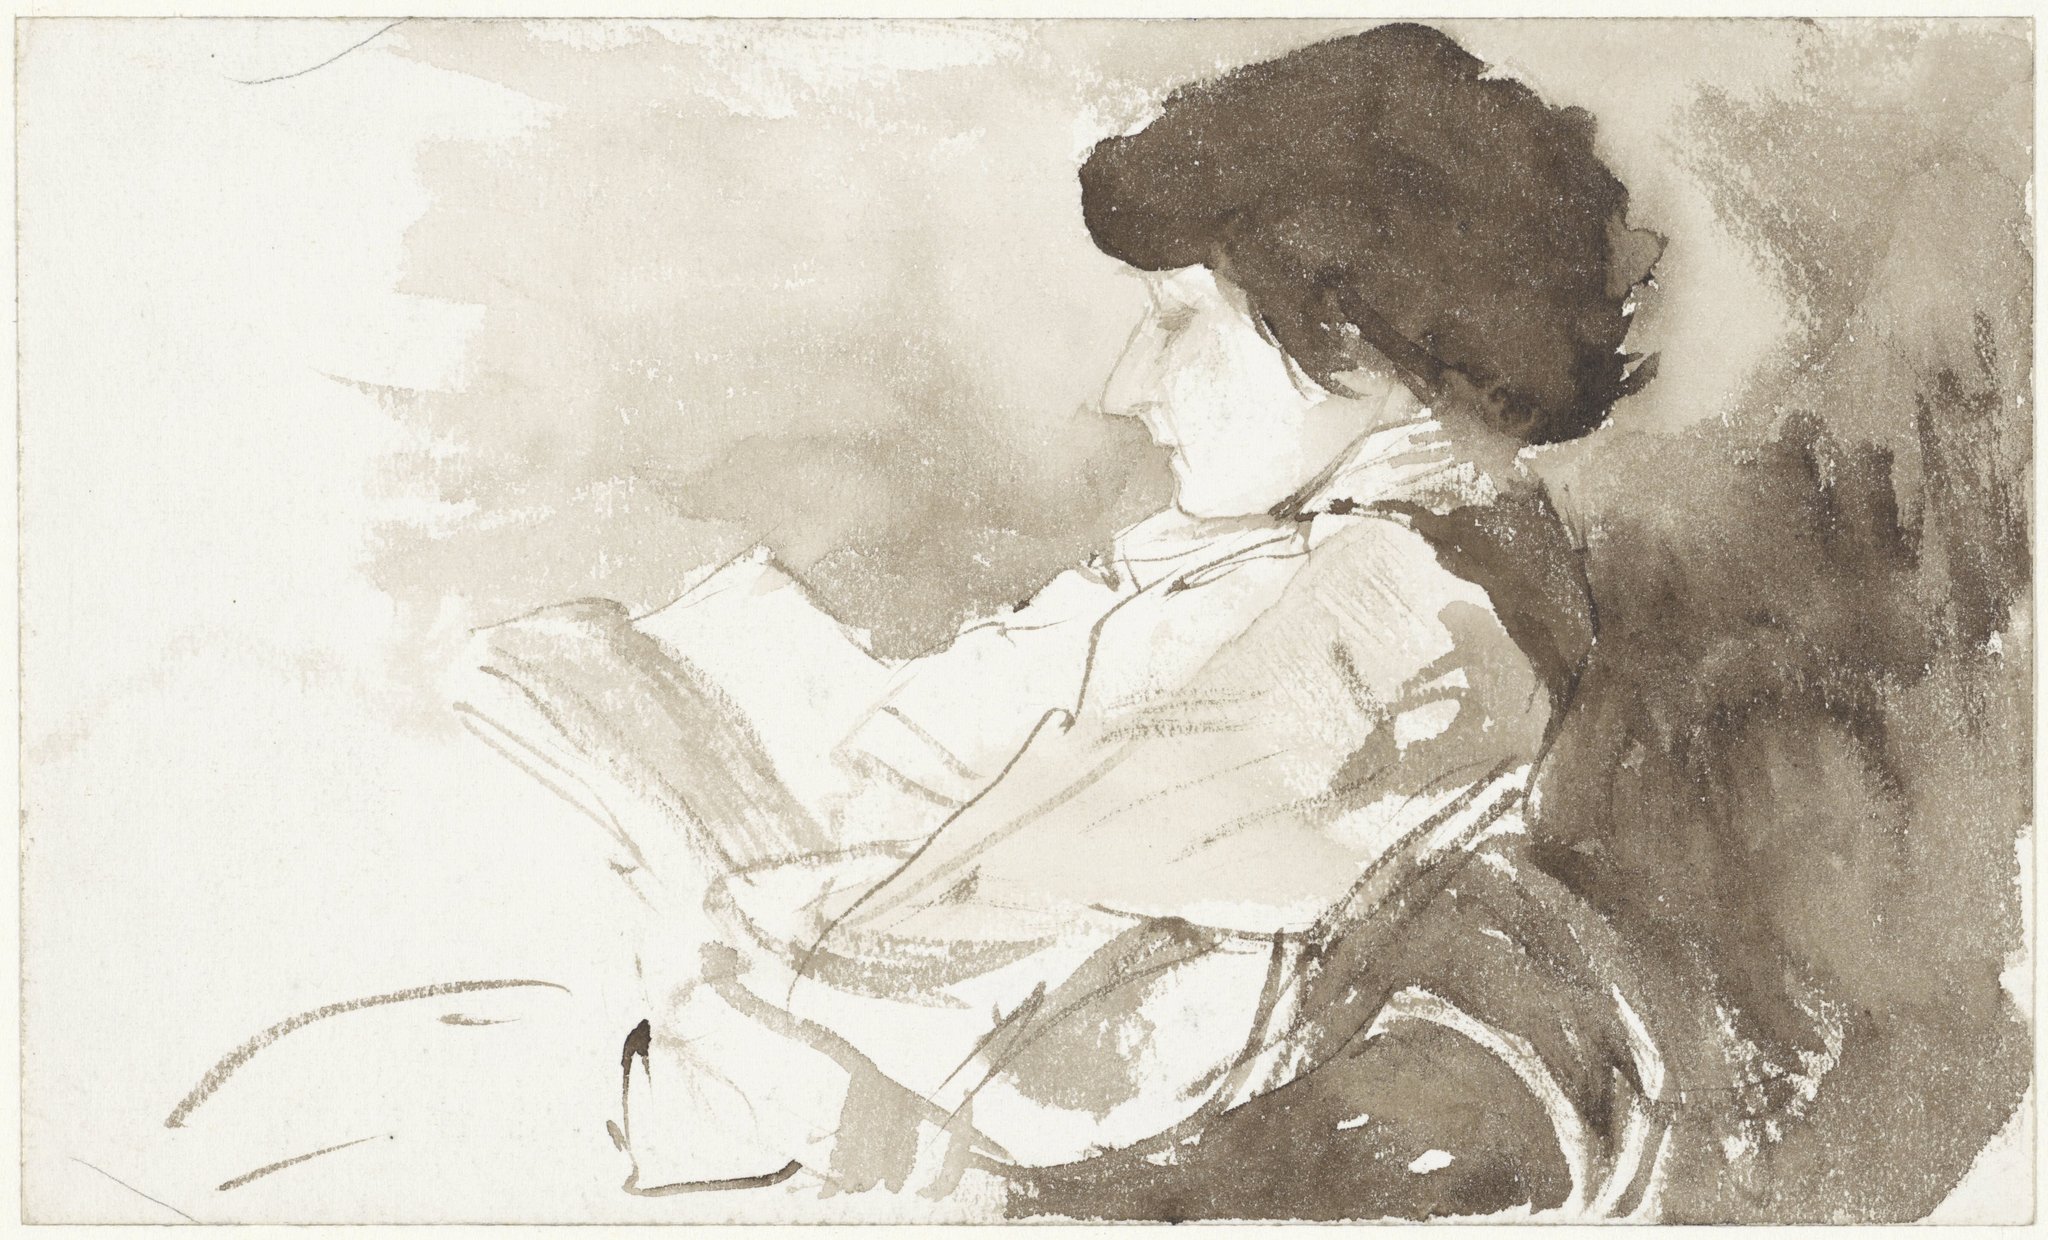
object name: drawing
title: Lezende vrouw, in profiel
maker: a.a.l. de grammont-hubrecht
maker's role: draughtsman, painter, print maker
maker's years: 1855-1913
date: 1865-1913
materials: paper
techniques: brush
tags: reading